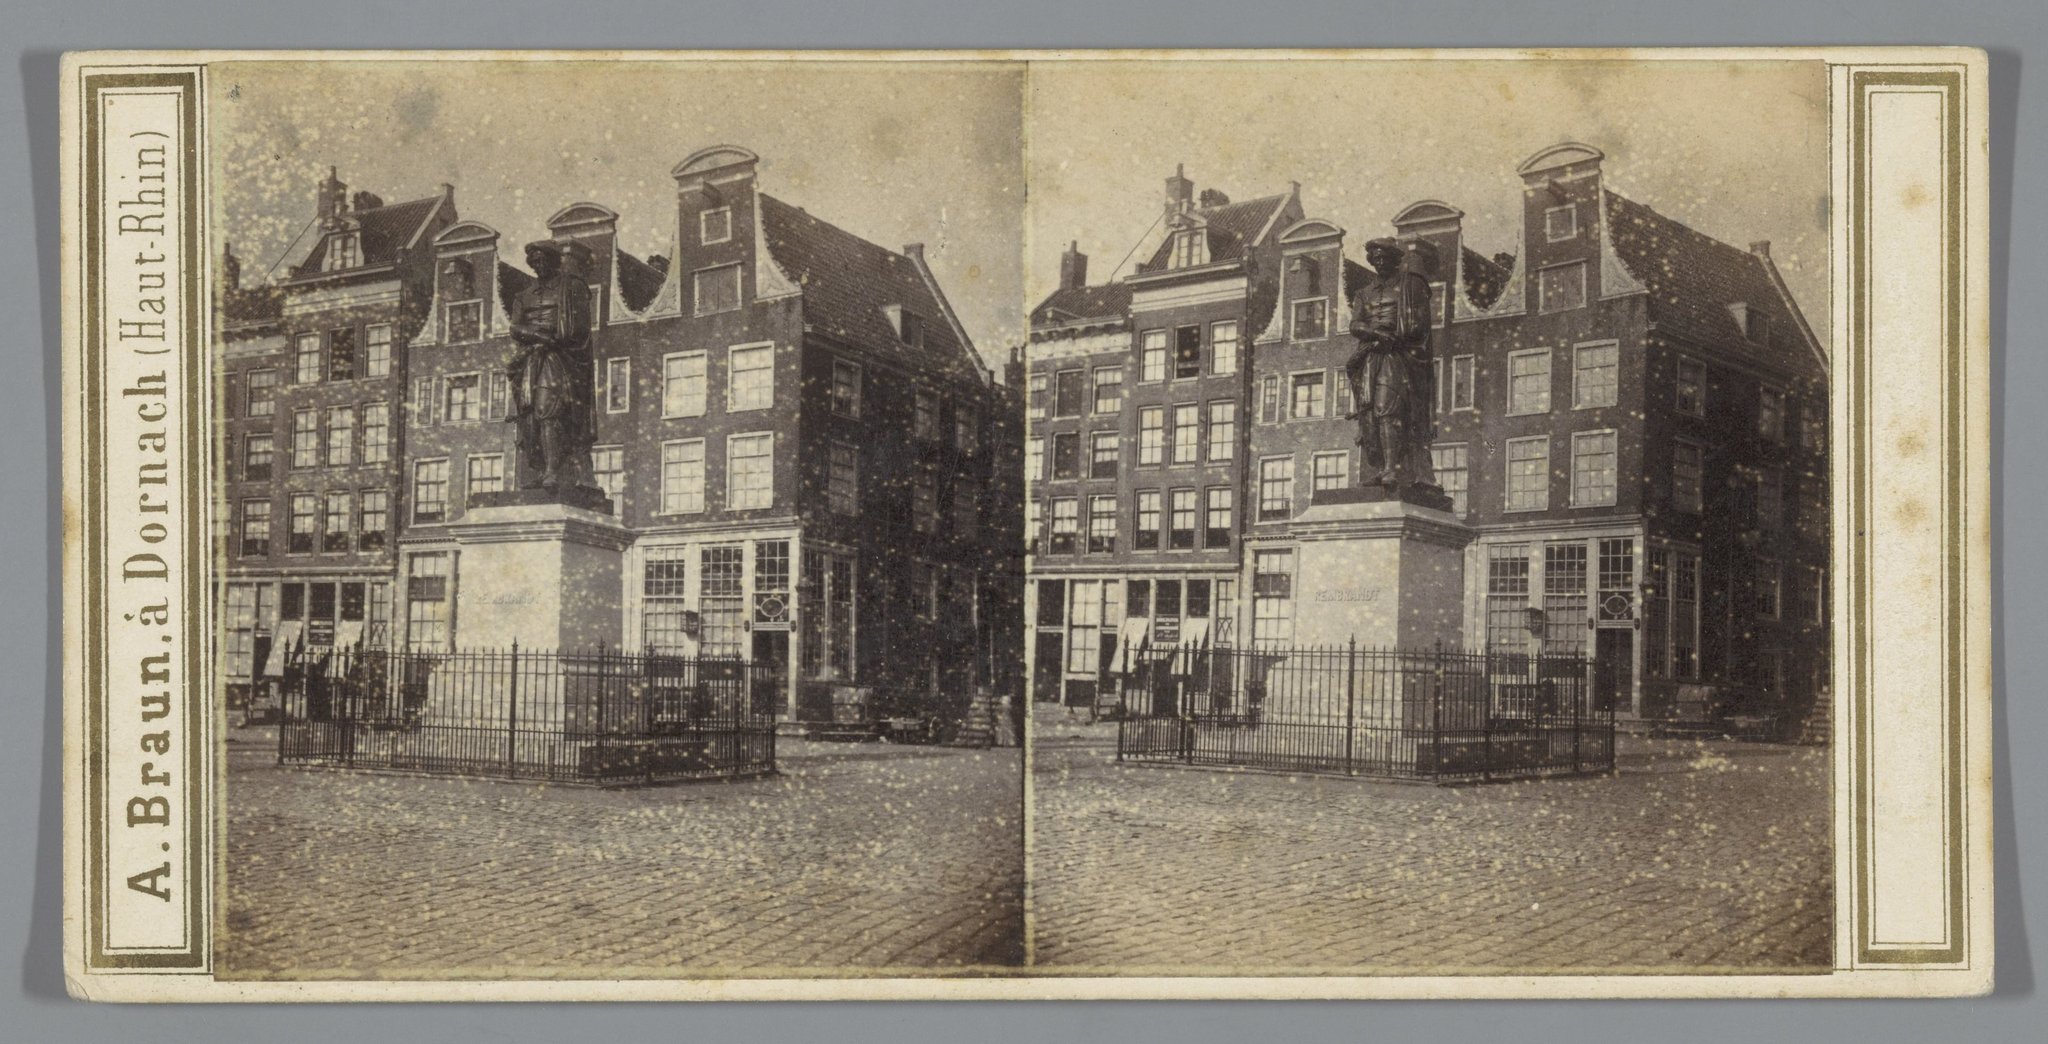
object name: stereograph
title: Rembrandtmonument op de Botermarkt, Amsterdam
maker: Anonymous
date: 1860-1863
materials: cardboard, paper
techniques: albumen print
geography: dornach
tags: monument, statue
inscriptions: number: ‘No 3983.’, inscription: ‘h’